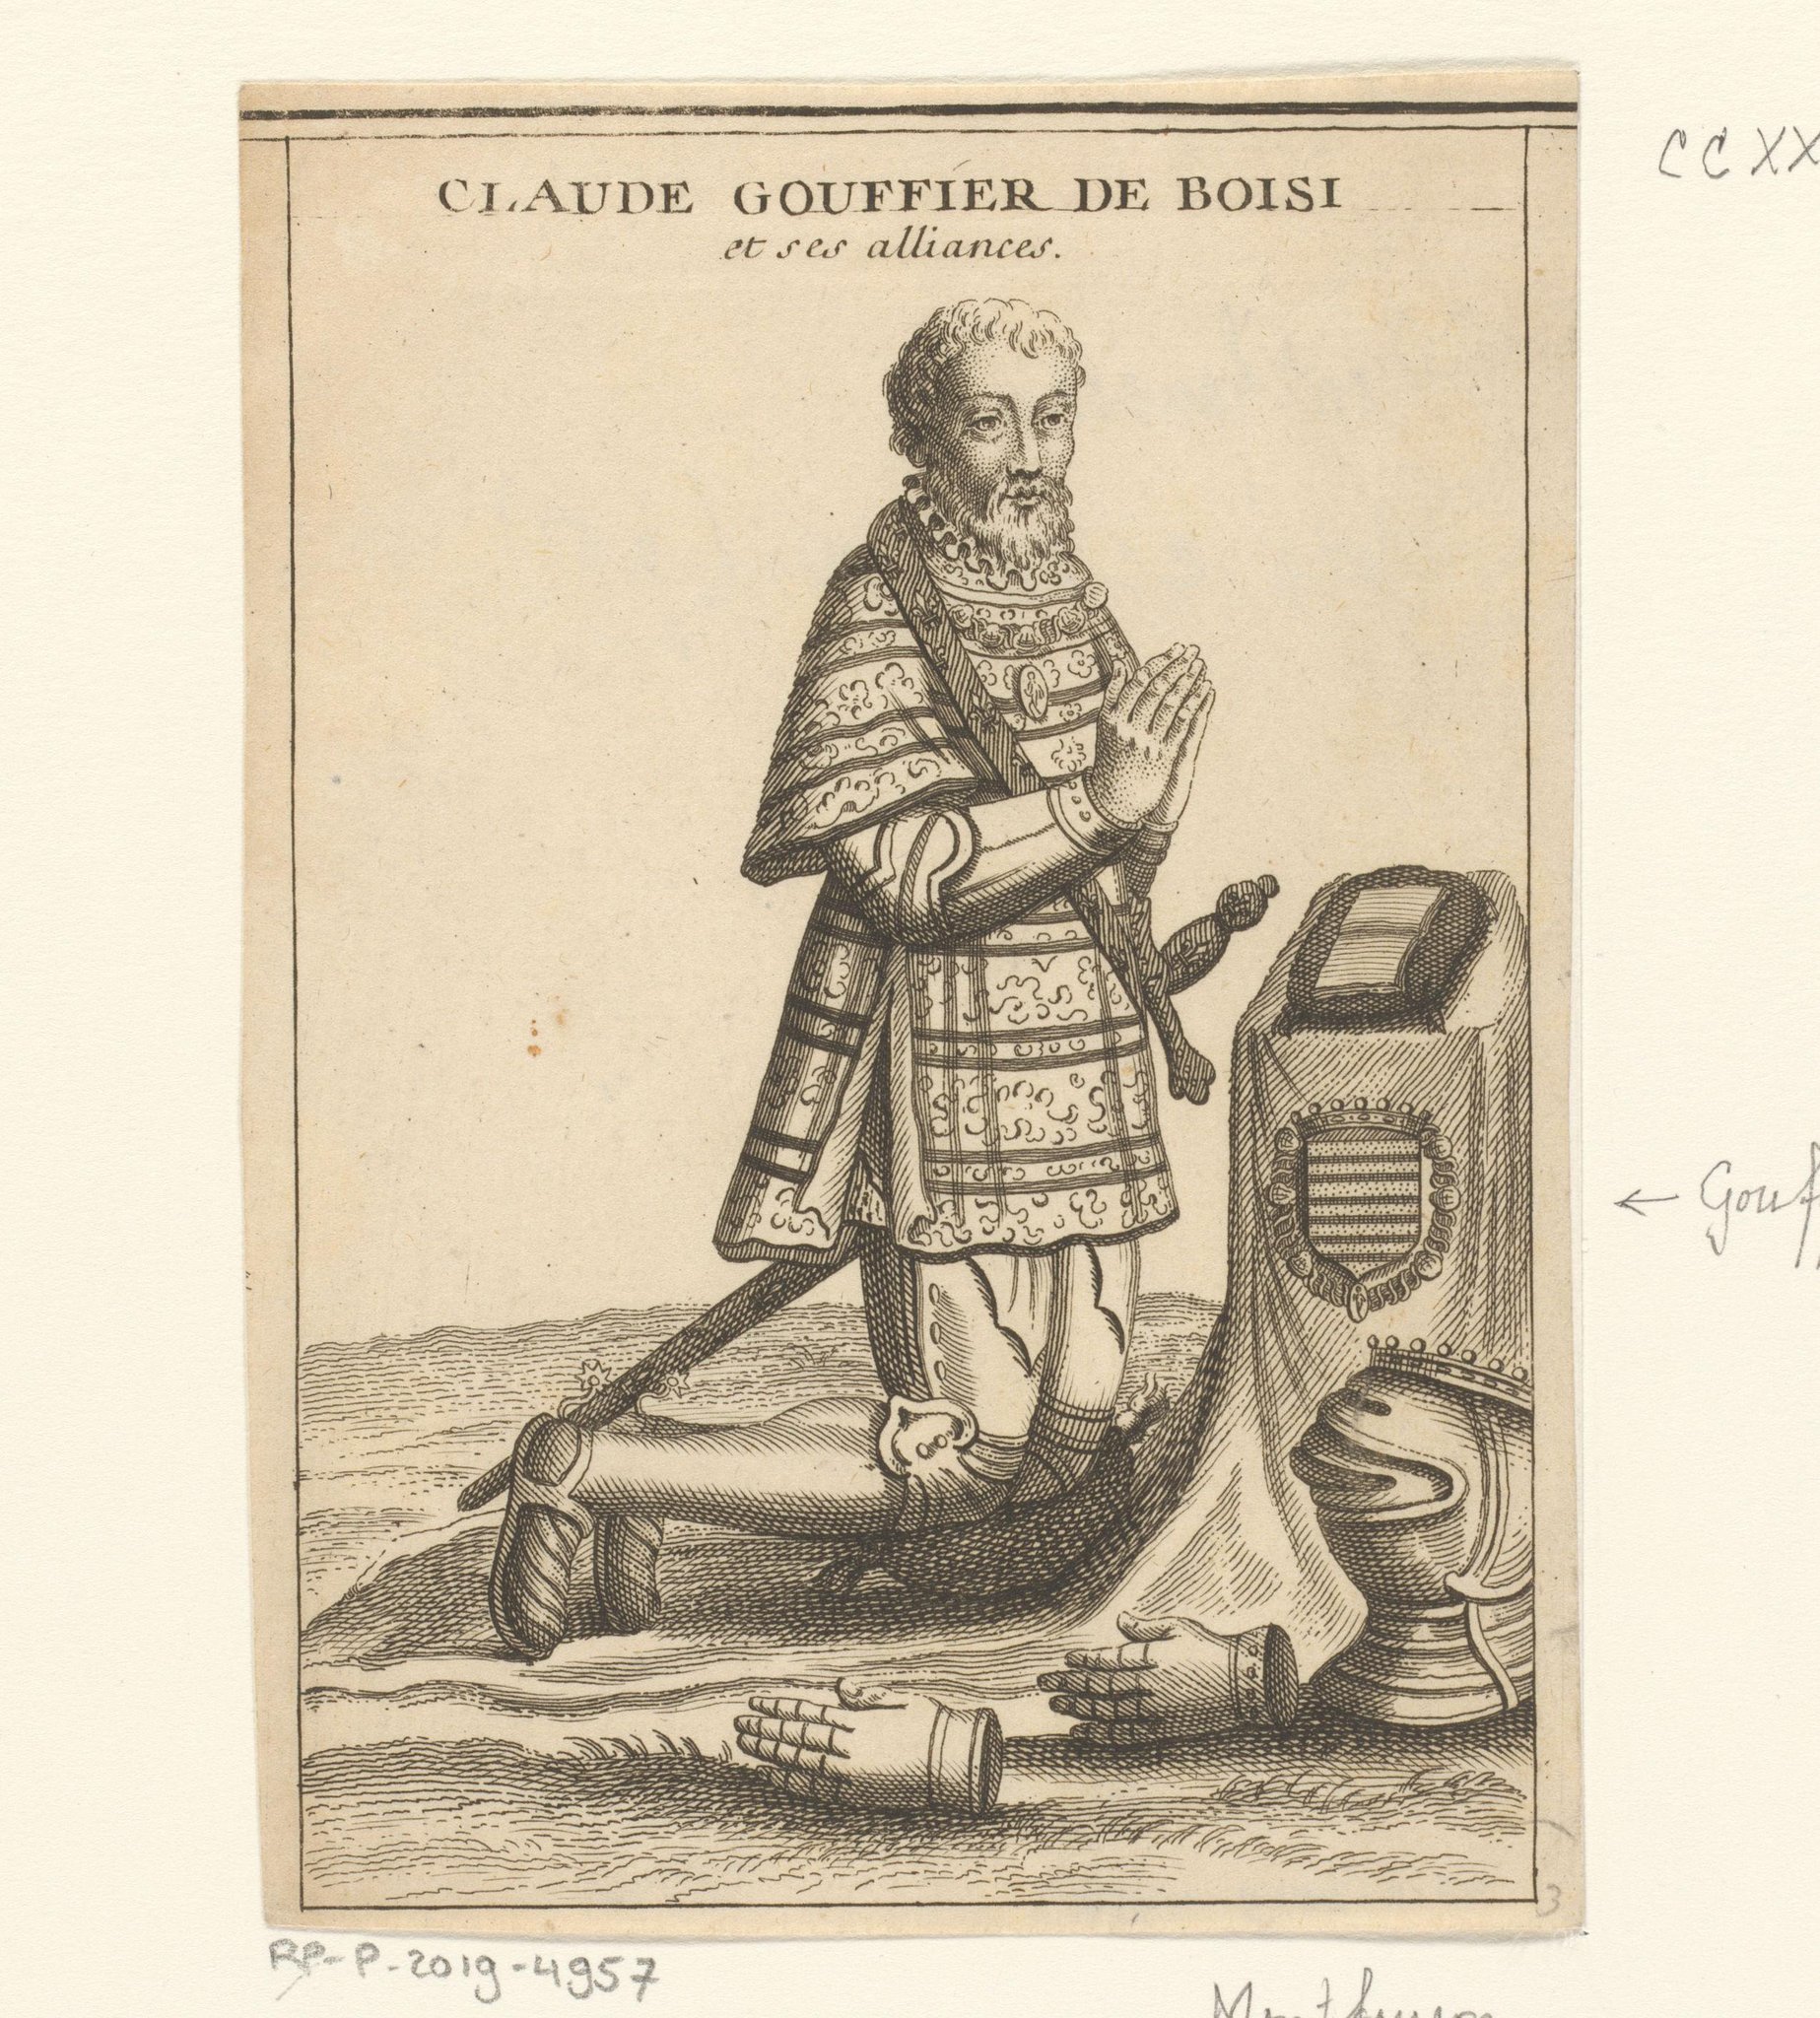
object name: book illustration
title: Portret van Claude Gouffier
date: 1729-1733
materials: paper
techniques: etching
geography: paris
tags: armour, historical persons, armorial bearing, heraldry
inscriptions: collector's mark: Lugt 2228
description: Prent uit: Montfaucon, Bernard de. Les monumens de la Monarchie Françoise (...). Parijs: Julien-Michel Gandouin en Pierre-François Giffart, 1729-1733.